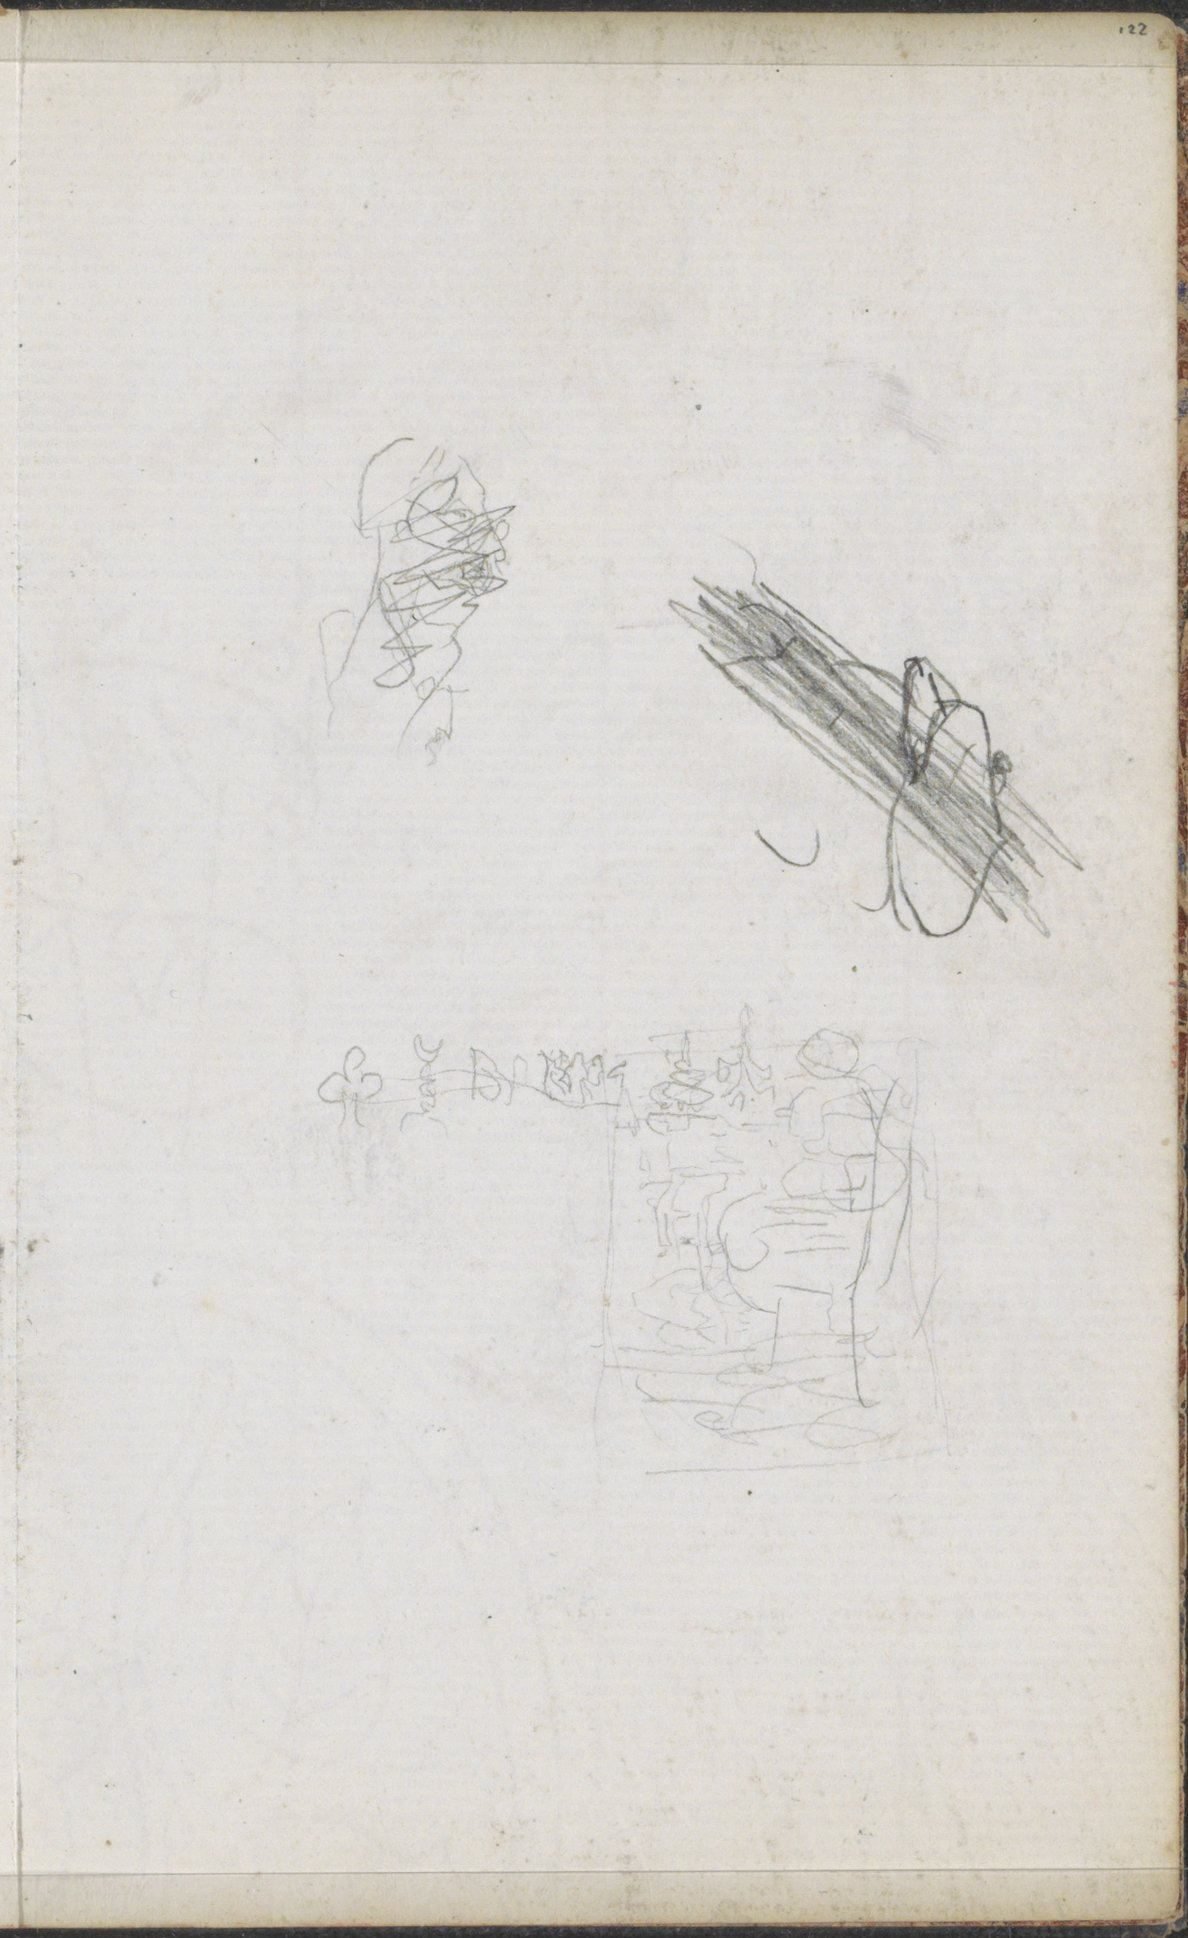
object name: sketchbook leaf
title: Straat en figuurstudie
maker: marius bauer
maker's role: draughtsman, print maker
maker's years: 1867-1932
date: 1897-1898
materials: pencil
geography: india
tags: head (human), street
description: Pagina 122 uit een schetsboek met 62 bladen.